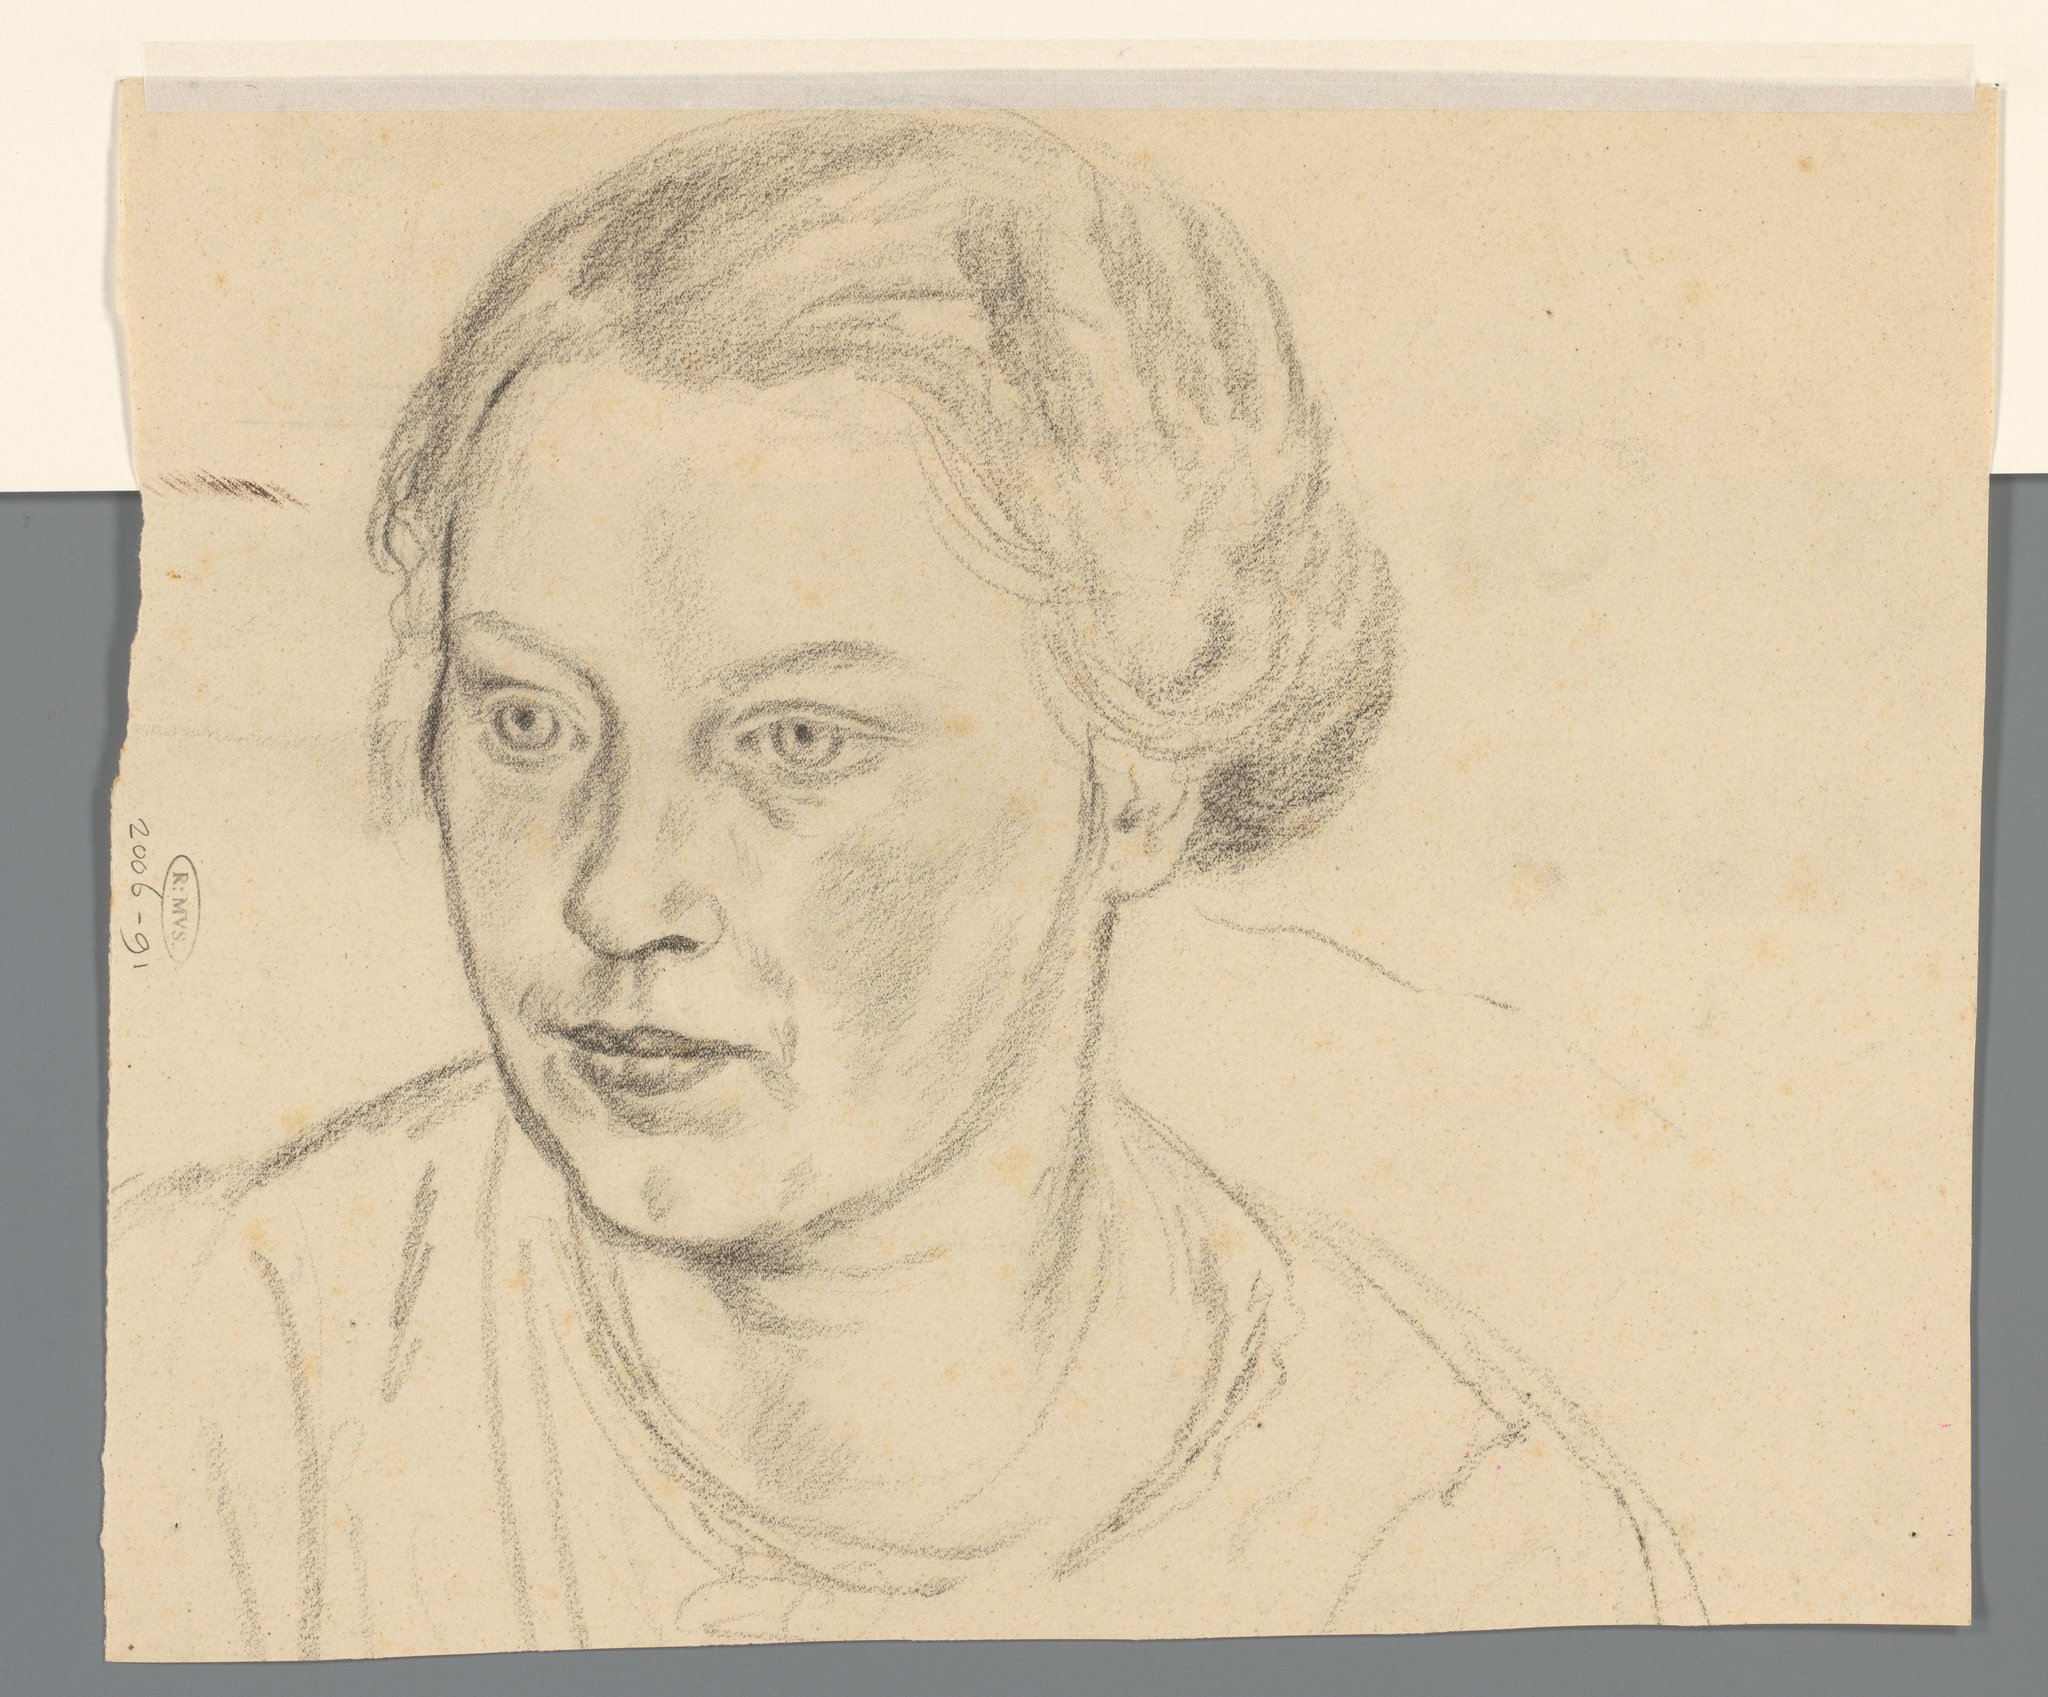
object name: drawing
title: Portret van een onbekende vrouw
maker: henk henriët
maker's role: draughtsman, print maker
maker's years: 1903-1945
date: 1913-1945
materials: chalk, paper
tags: anonymous historical person portrayed - bb - woman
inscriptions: collector's mark: Lugt 2228